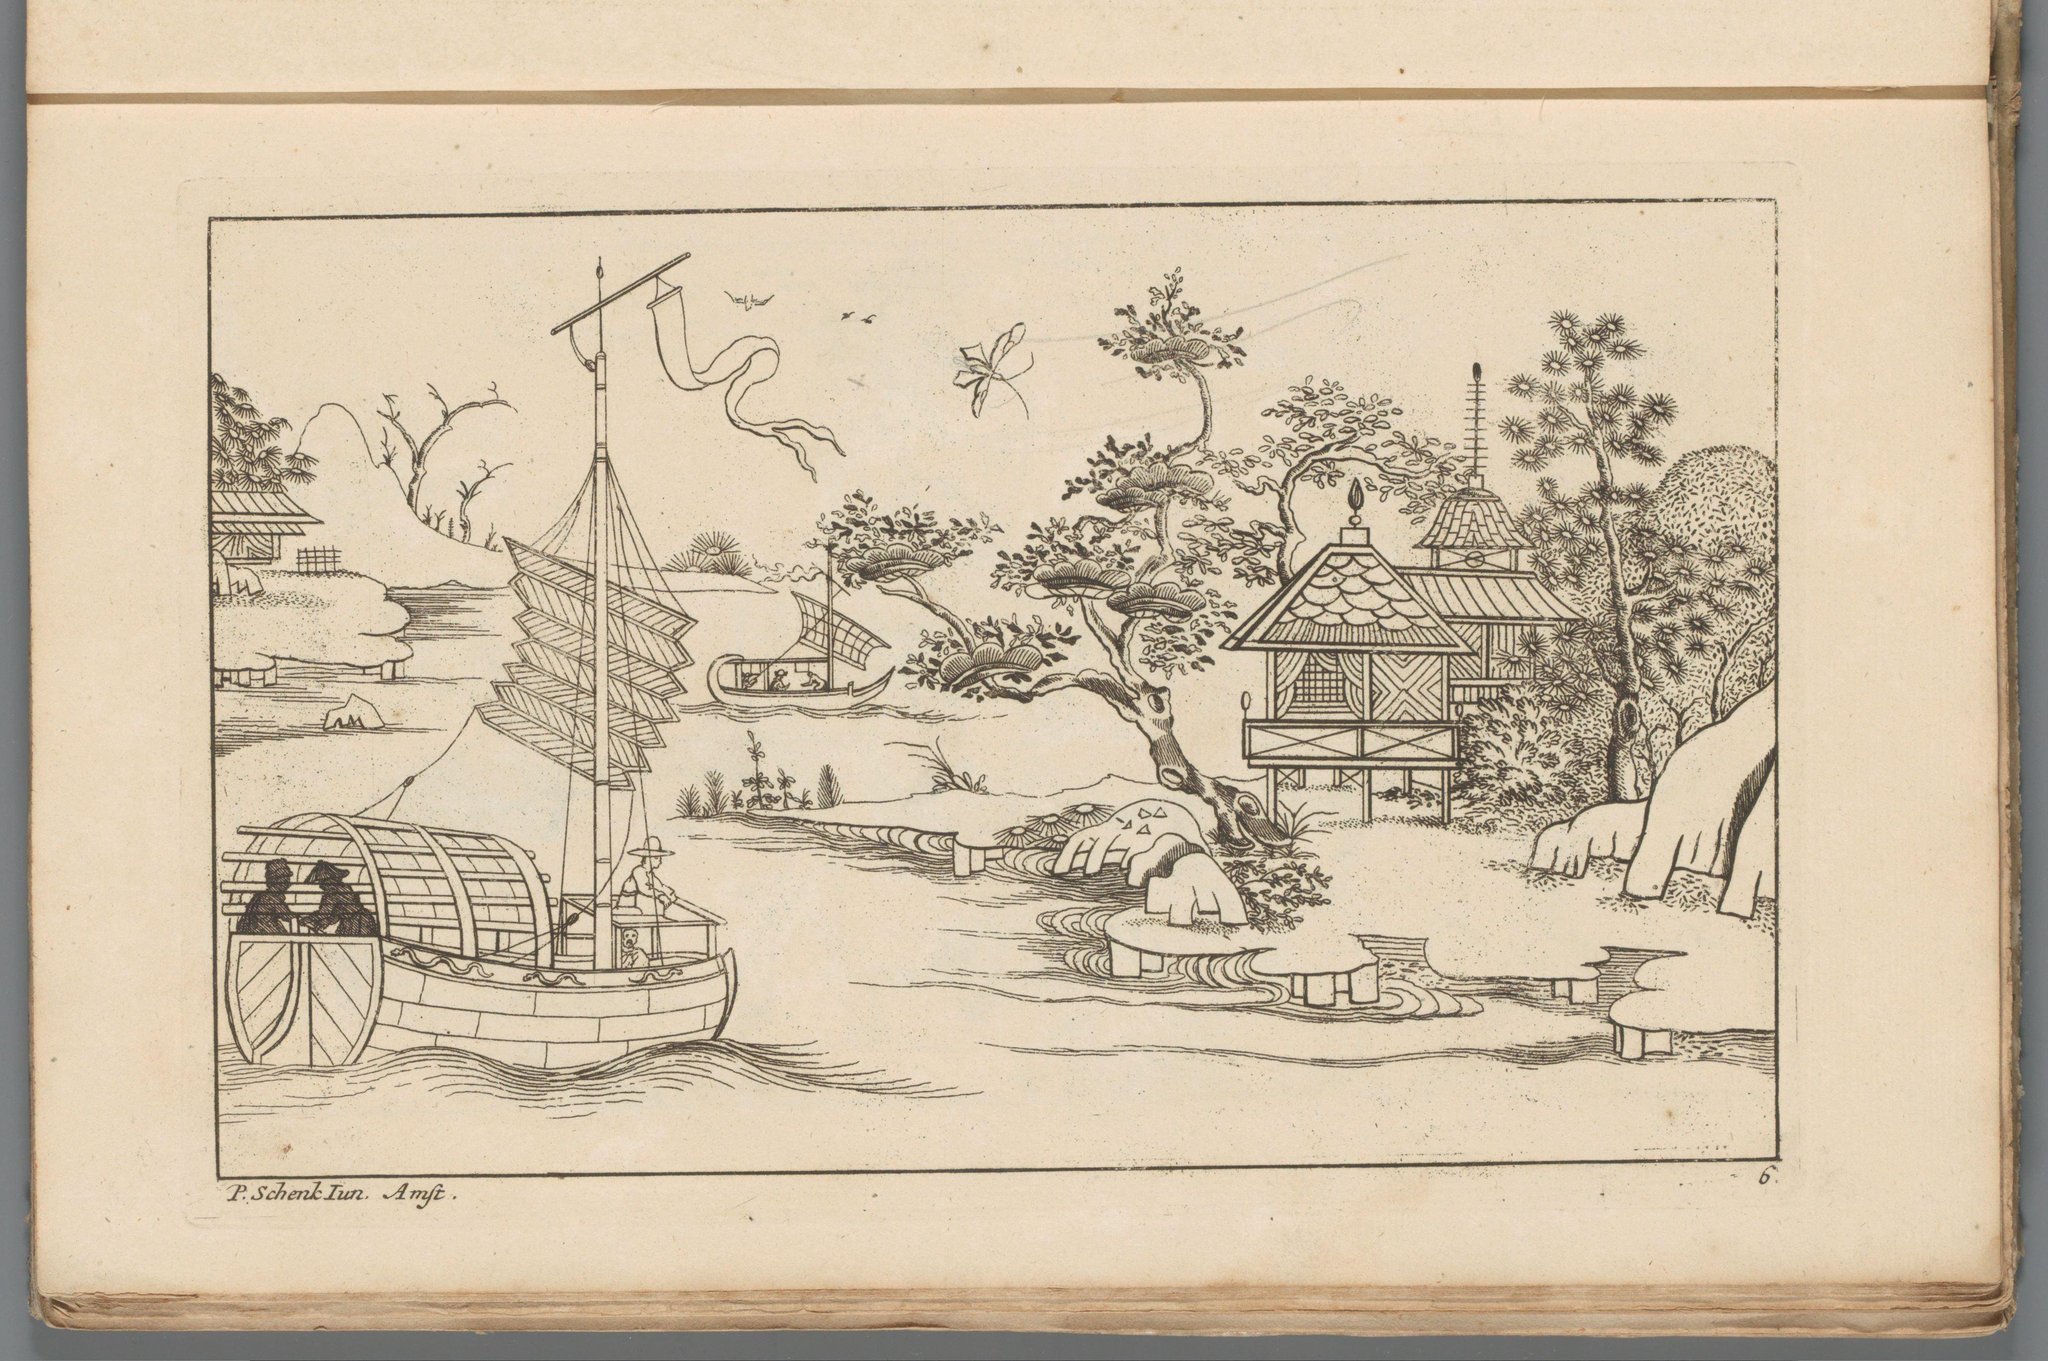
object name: ornament print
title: Nieuwe geinventeerde Sineesen, met groote moeyte geteekent en in 't Ligt gegeven, door P: Schenk Jun (...), eerste deel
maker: pieter schenk (ii)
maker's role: draughtsman, print maker, publisher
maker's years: 1693-1775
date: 1727-1775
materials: paper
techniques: etching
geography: amsterdam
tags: sailing-ship, sailing-boat, chinese, landscapes in the temperate zone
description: Chinees landschap met twee zeilschepen op een rivier. Rechts op de oever een gebouw. Prent maakt deel uit van een album.